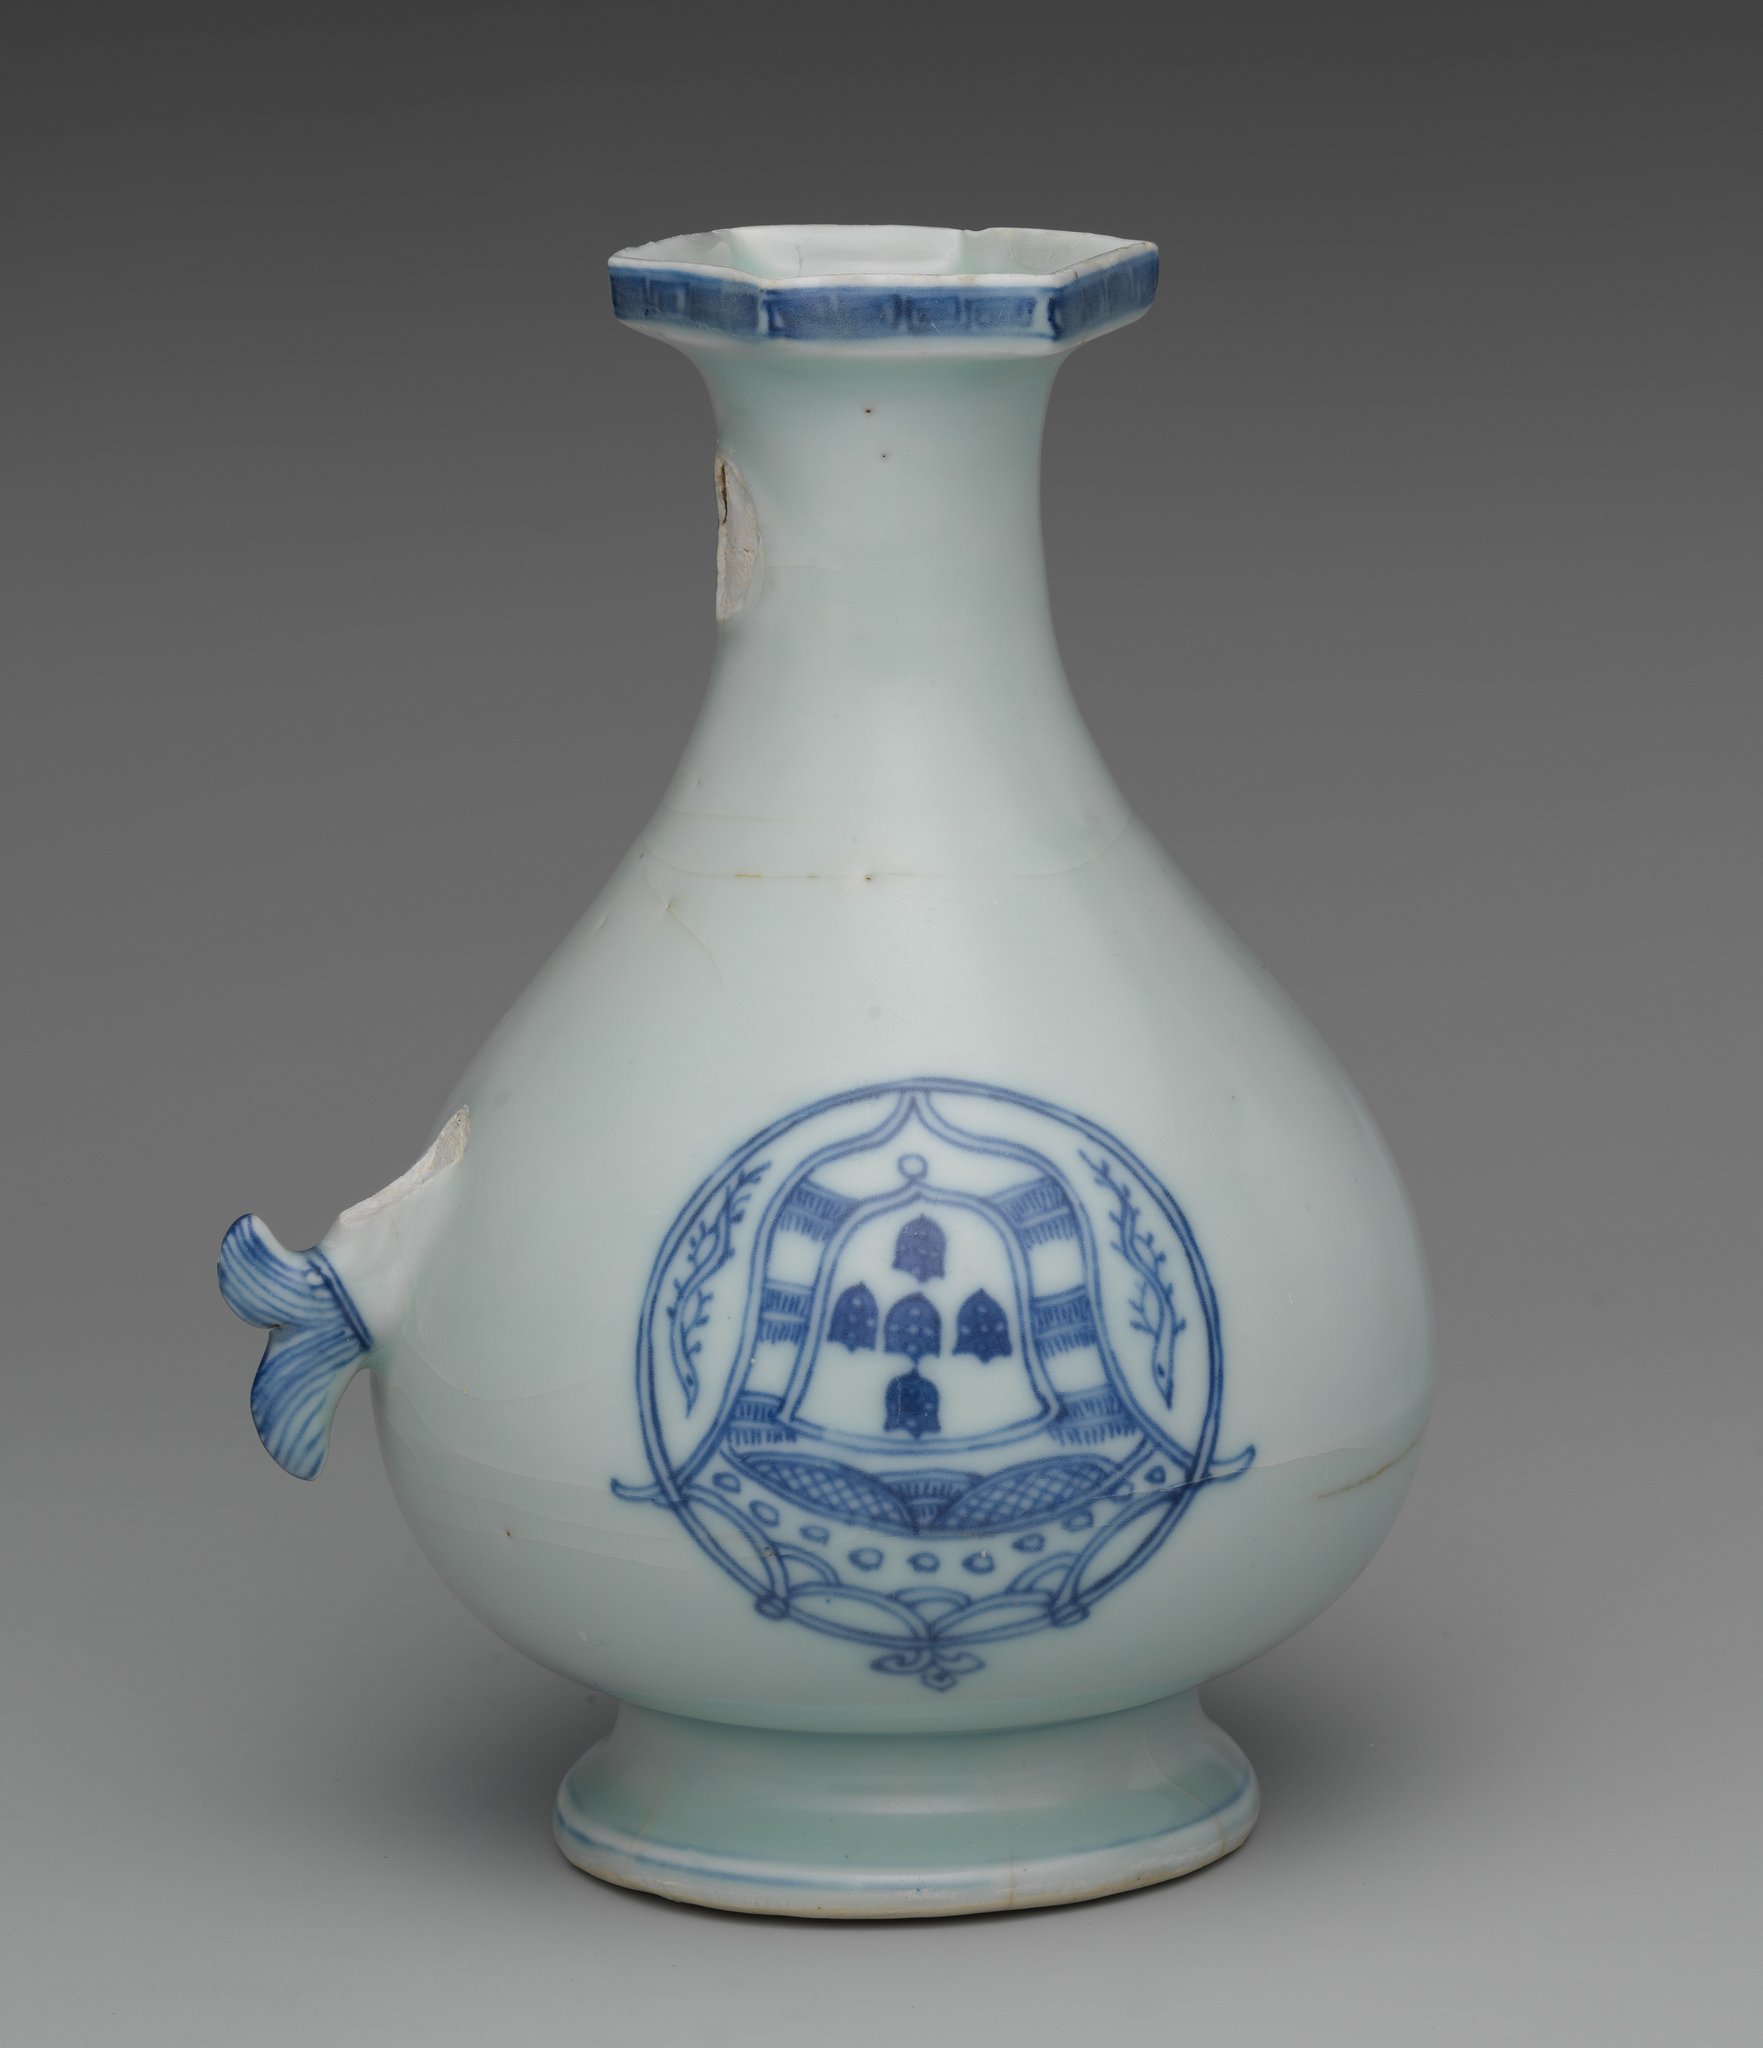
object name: jug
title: Jug with Portuguese arms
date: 1520-1540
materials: cobalt, glaze, hard paste porcelain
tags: coat of arms